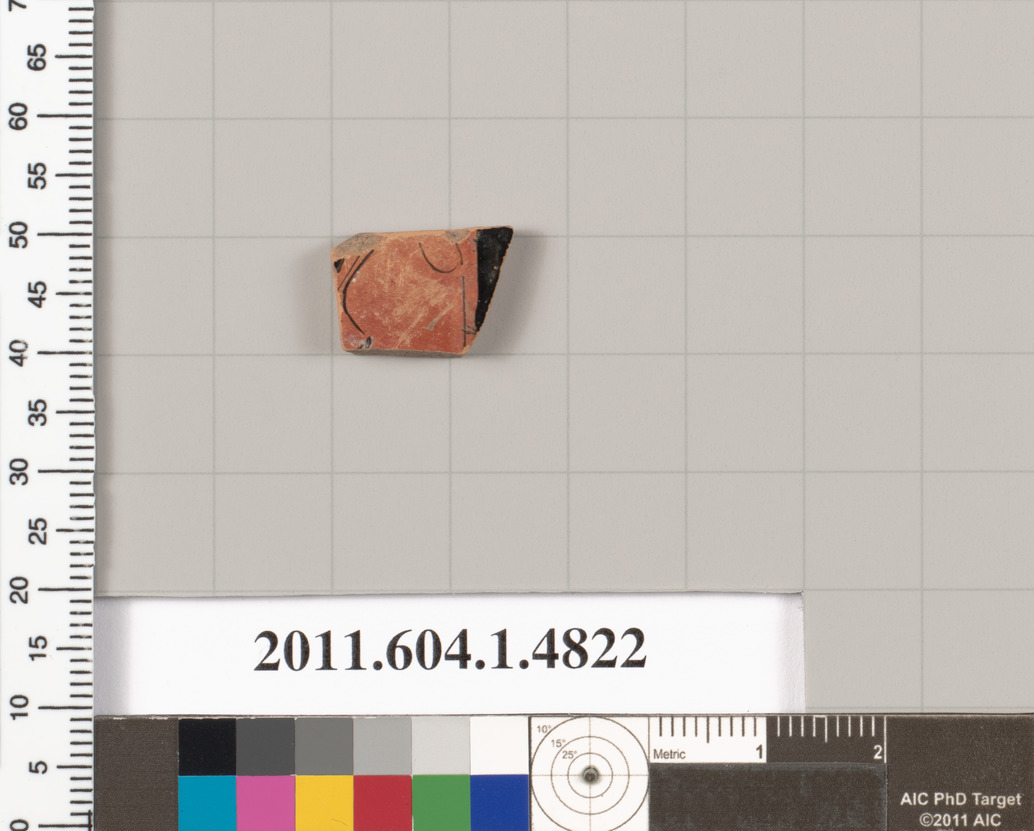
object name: kylix fragment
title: Terracotta fragment of a kylix (drinking cup)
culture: greek, attic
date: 490-470 BCE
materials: terracotta